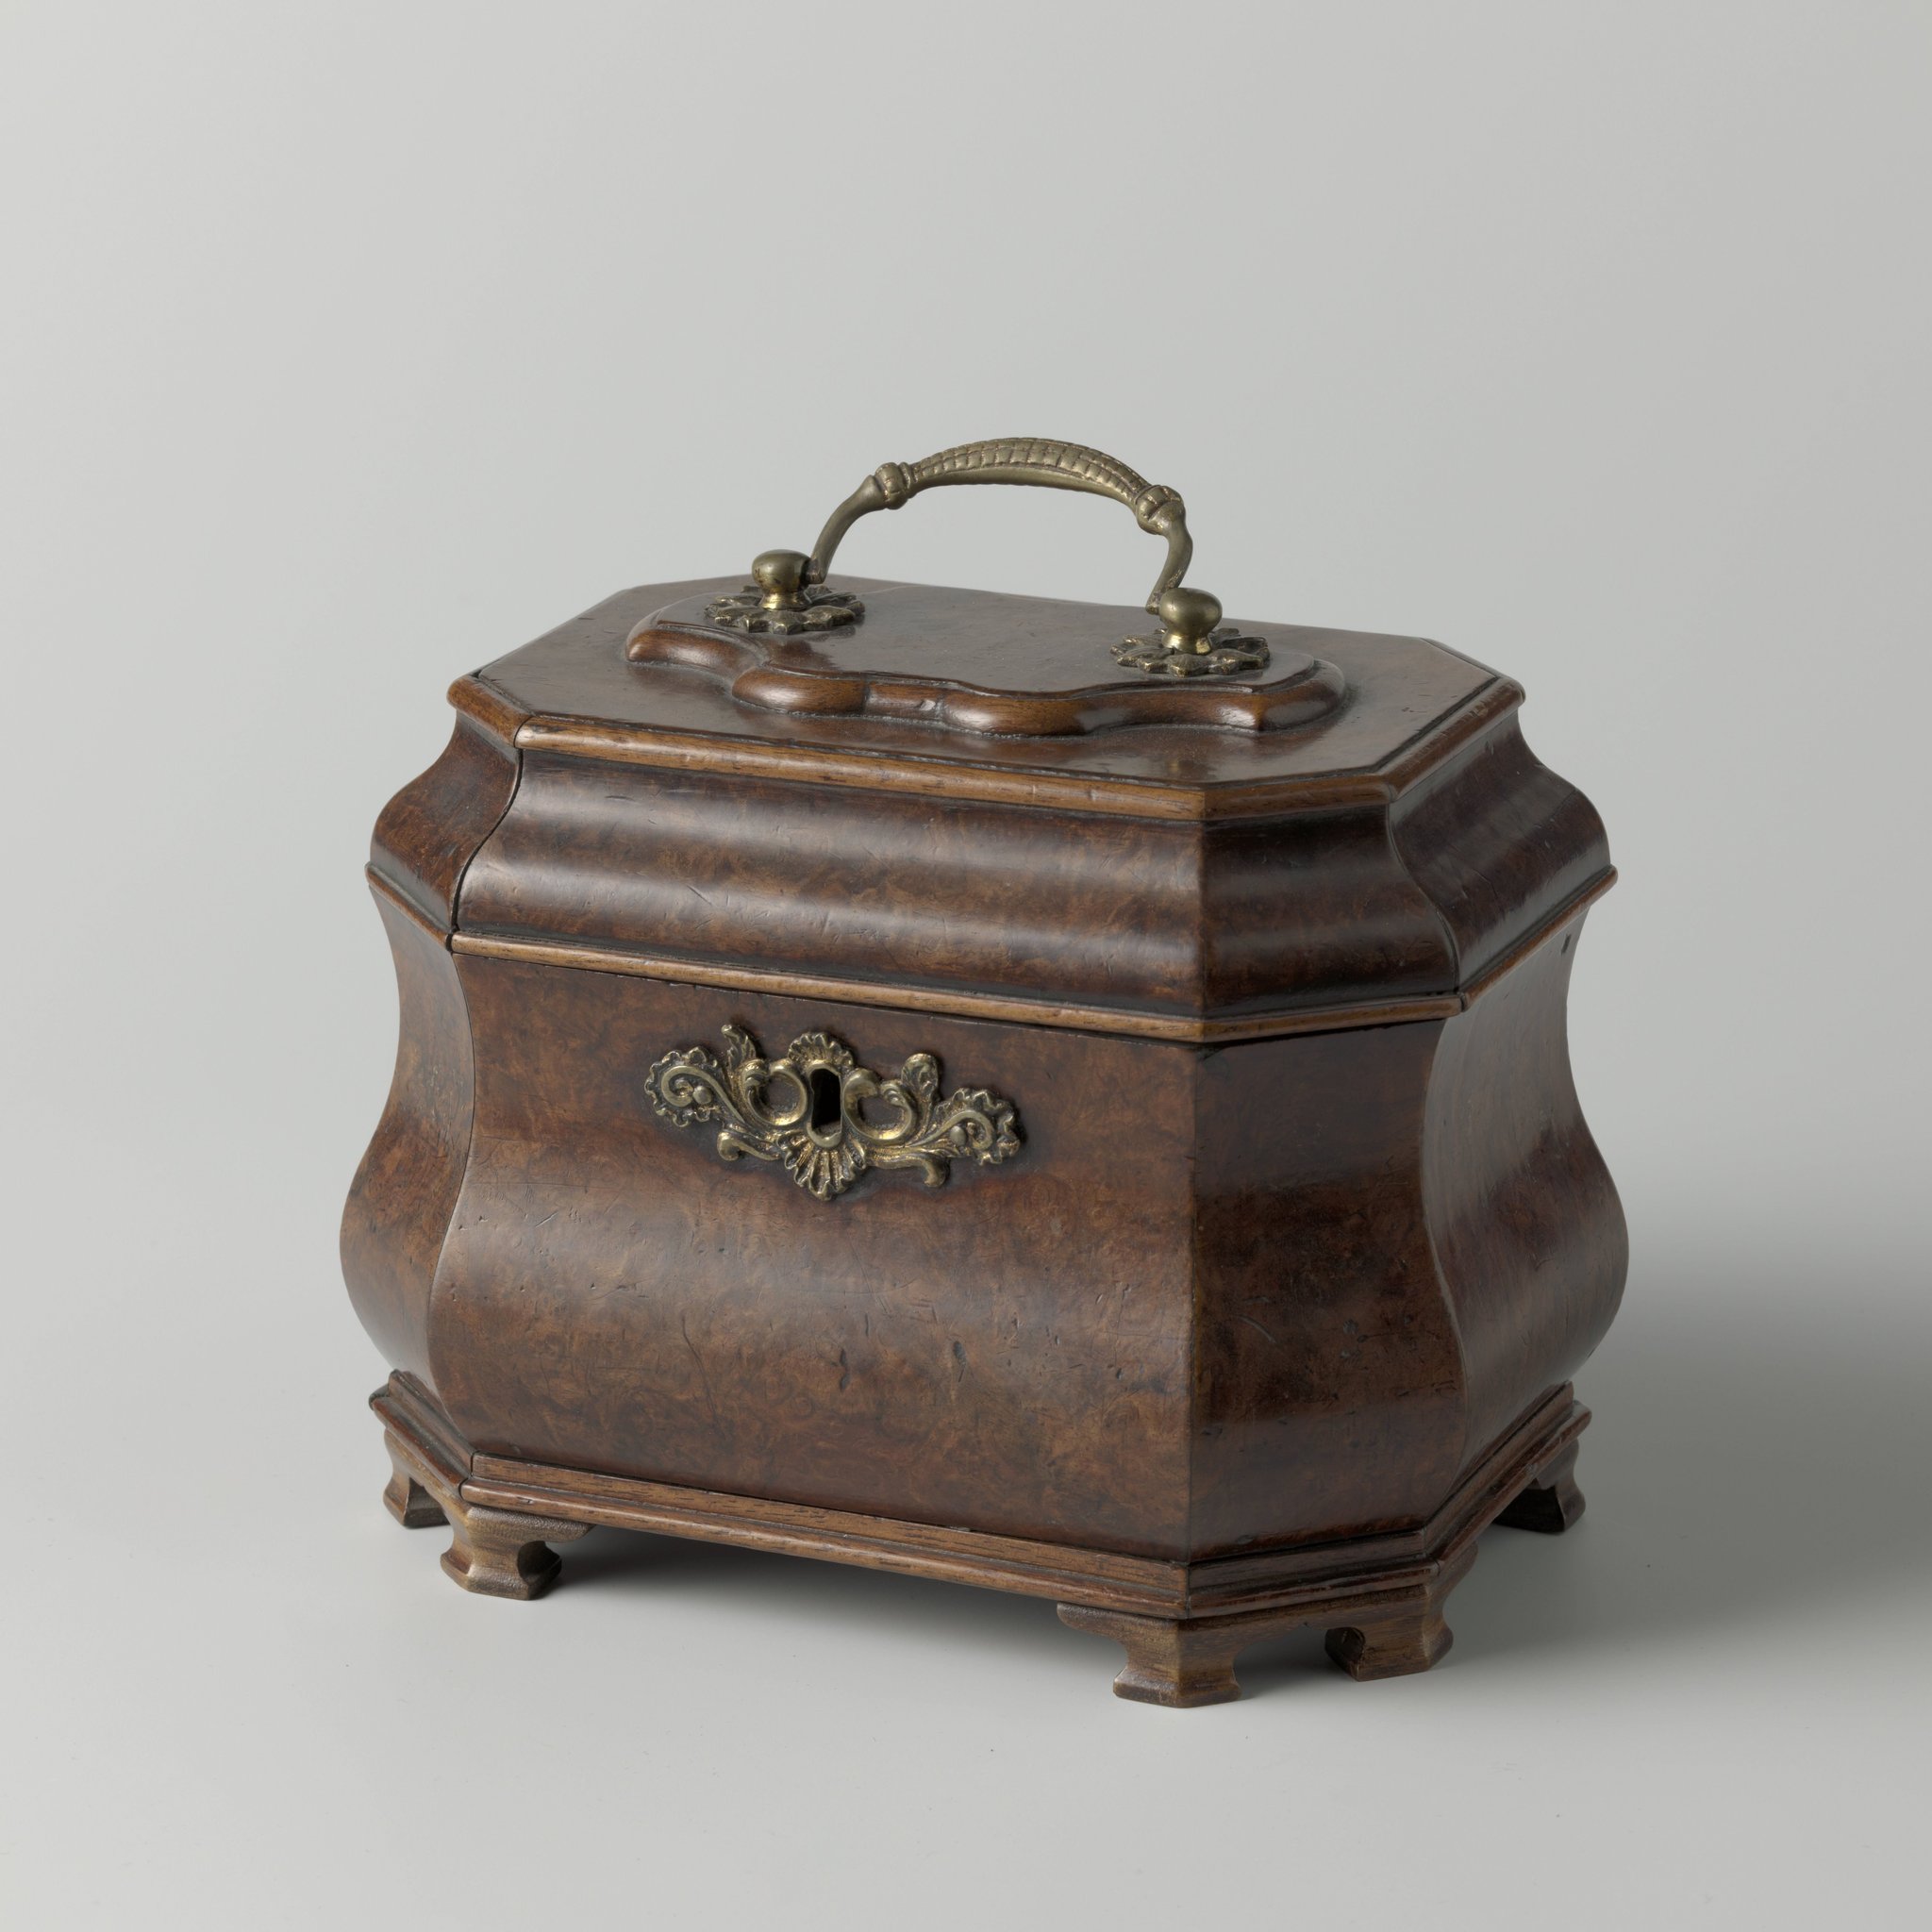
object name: chest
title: Kist, met wortelnotenhout belijmd. Achthoekig, met gebogen wanden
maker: Anonymous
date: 1750-1775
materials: bronze, wood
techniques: gilding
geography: netherlands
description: Kist van eikenhout, belijmd met wortelnotenhout. Achthoekig van vorm, de wanden gebogen. Beslag en hengsel van verguld brons. Binnenkant bekleed met groen velours.